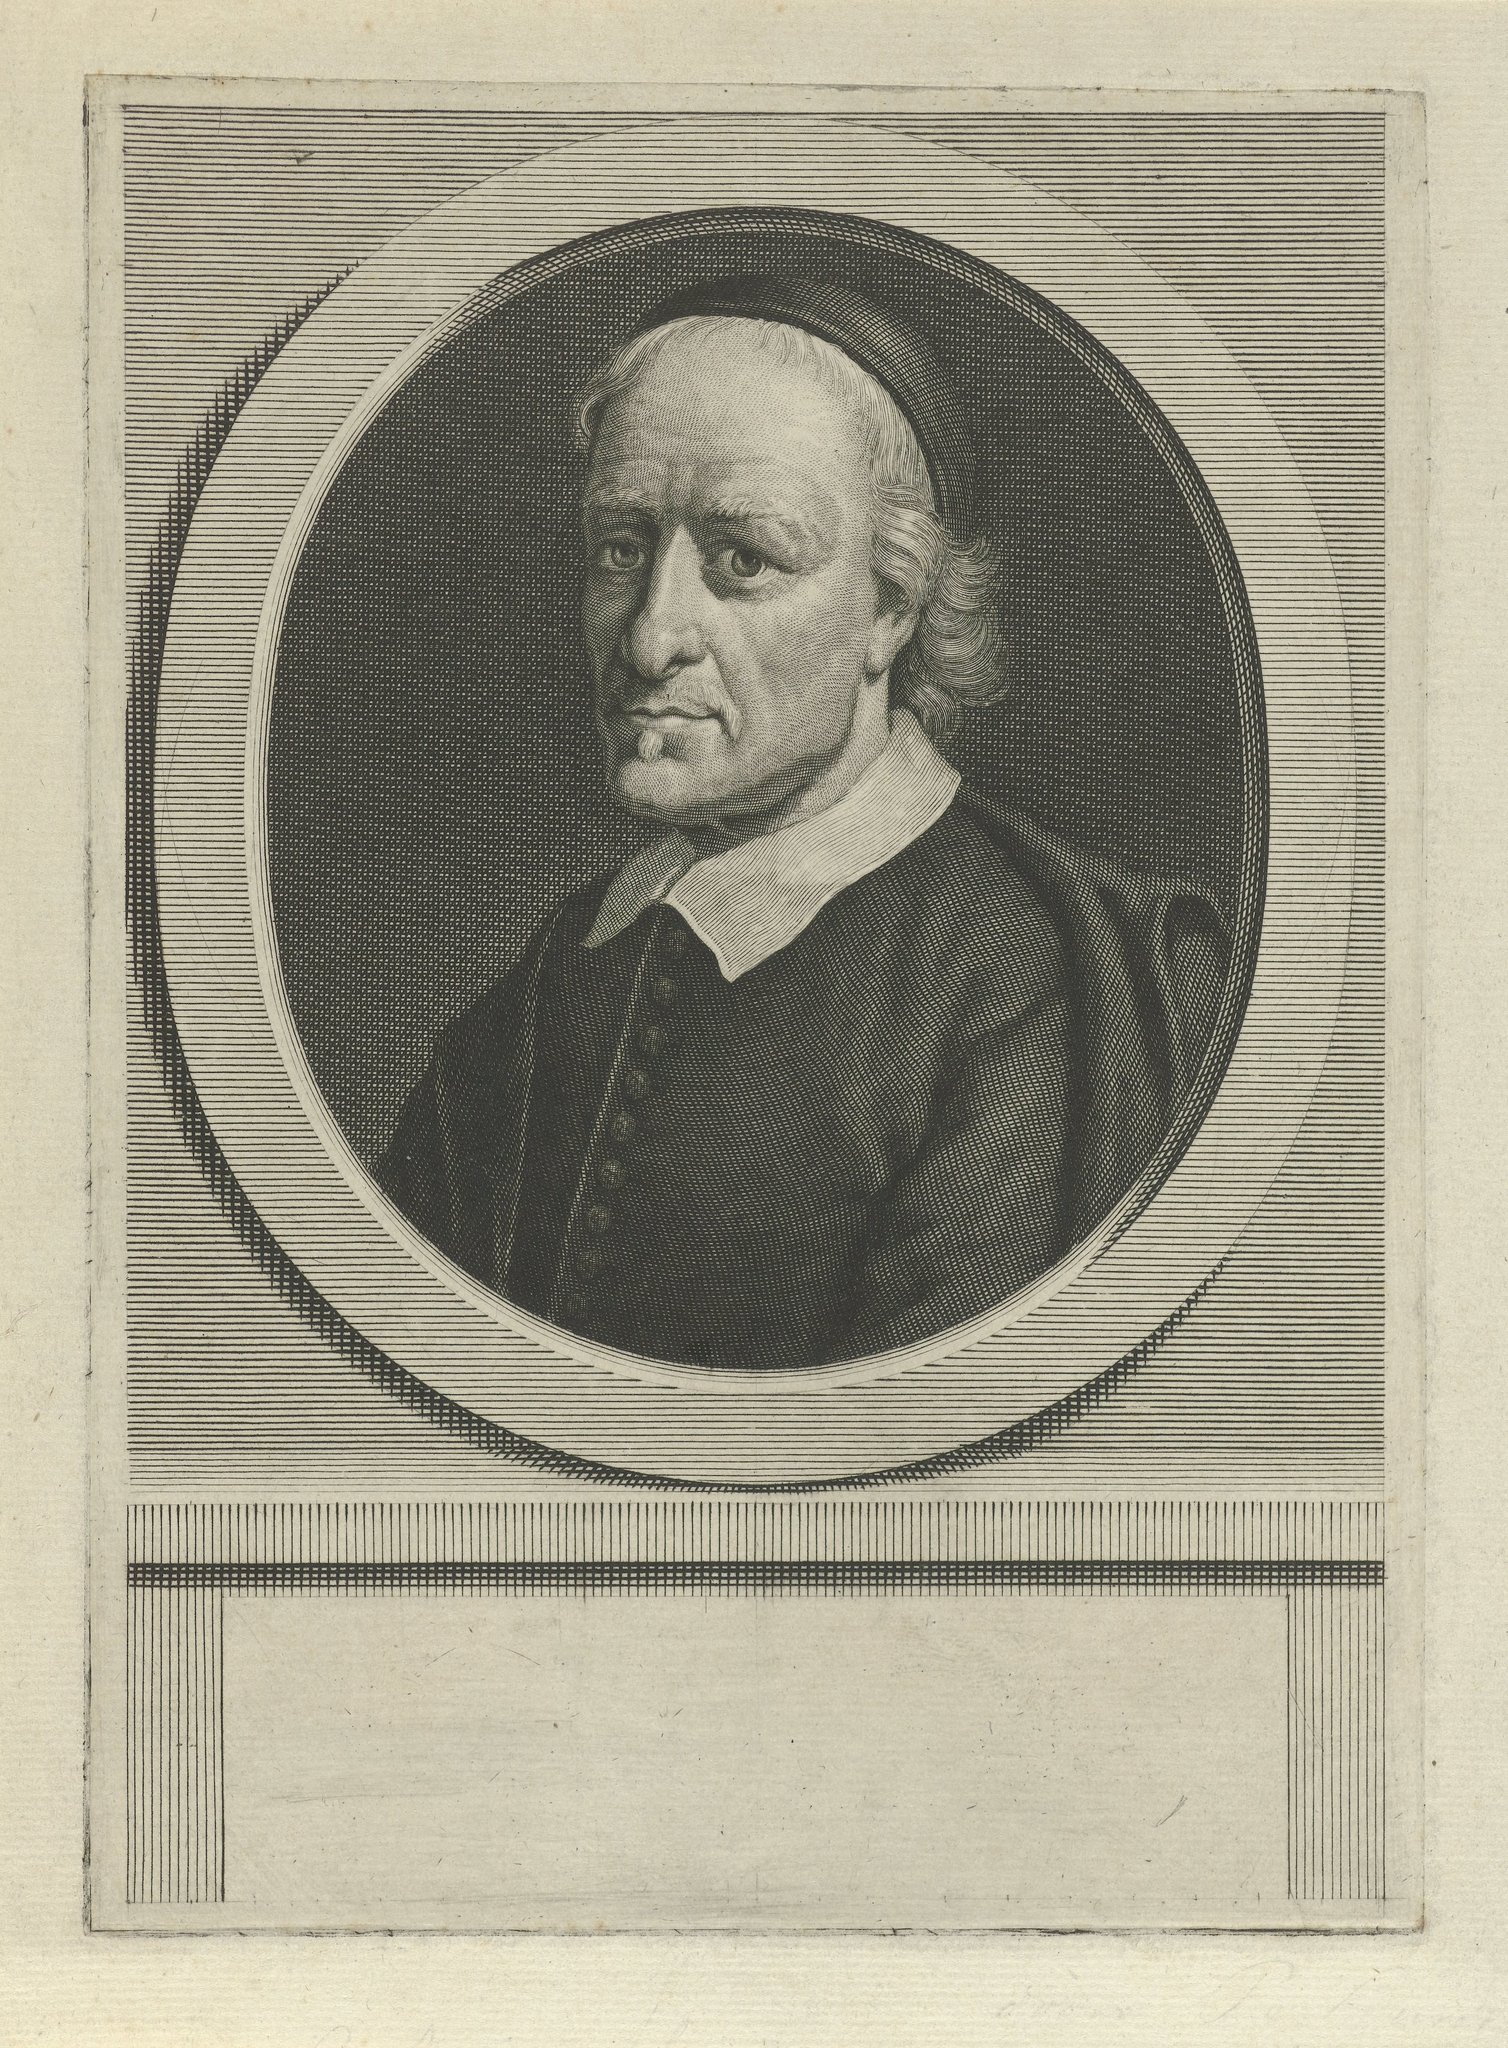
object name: print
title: Portret van Galenus Abrahamsz. de Haan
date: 1706-1731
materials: paper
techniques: engraving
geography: amsterdam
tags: amsterdam, galenus abrahamsz. de haan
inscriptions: collector's mark: Lugt 240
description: Galenus Abrahamsz. de Haan, doopsgezinde predikant en geneesheer te Amsterdam.